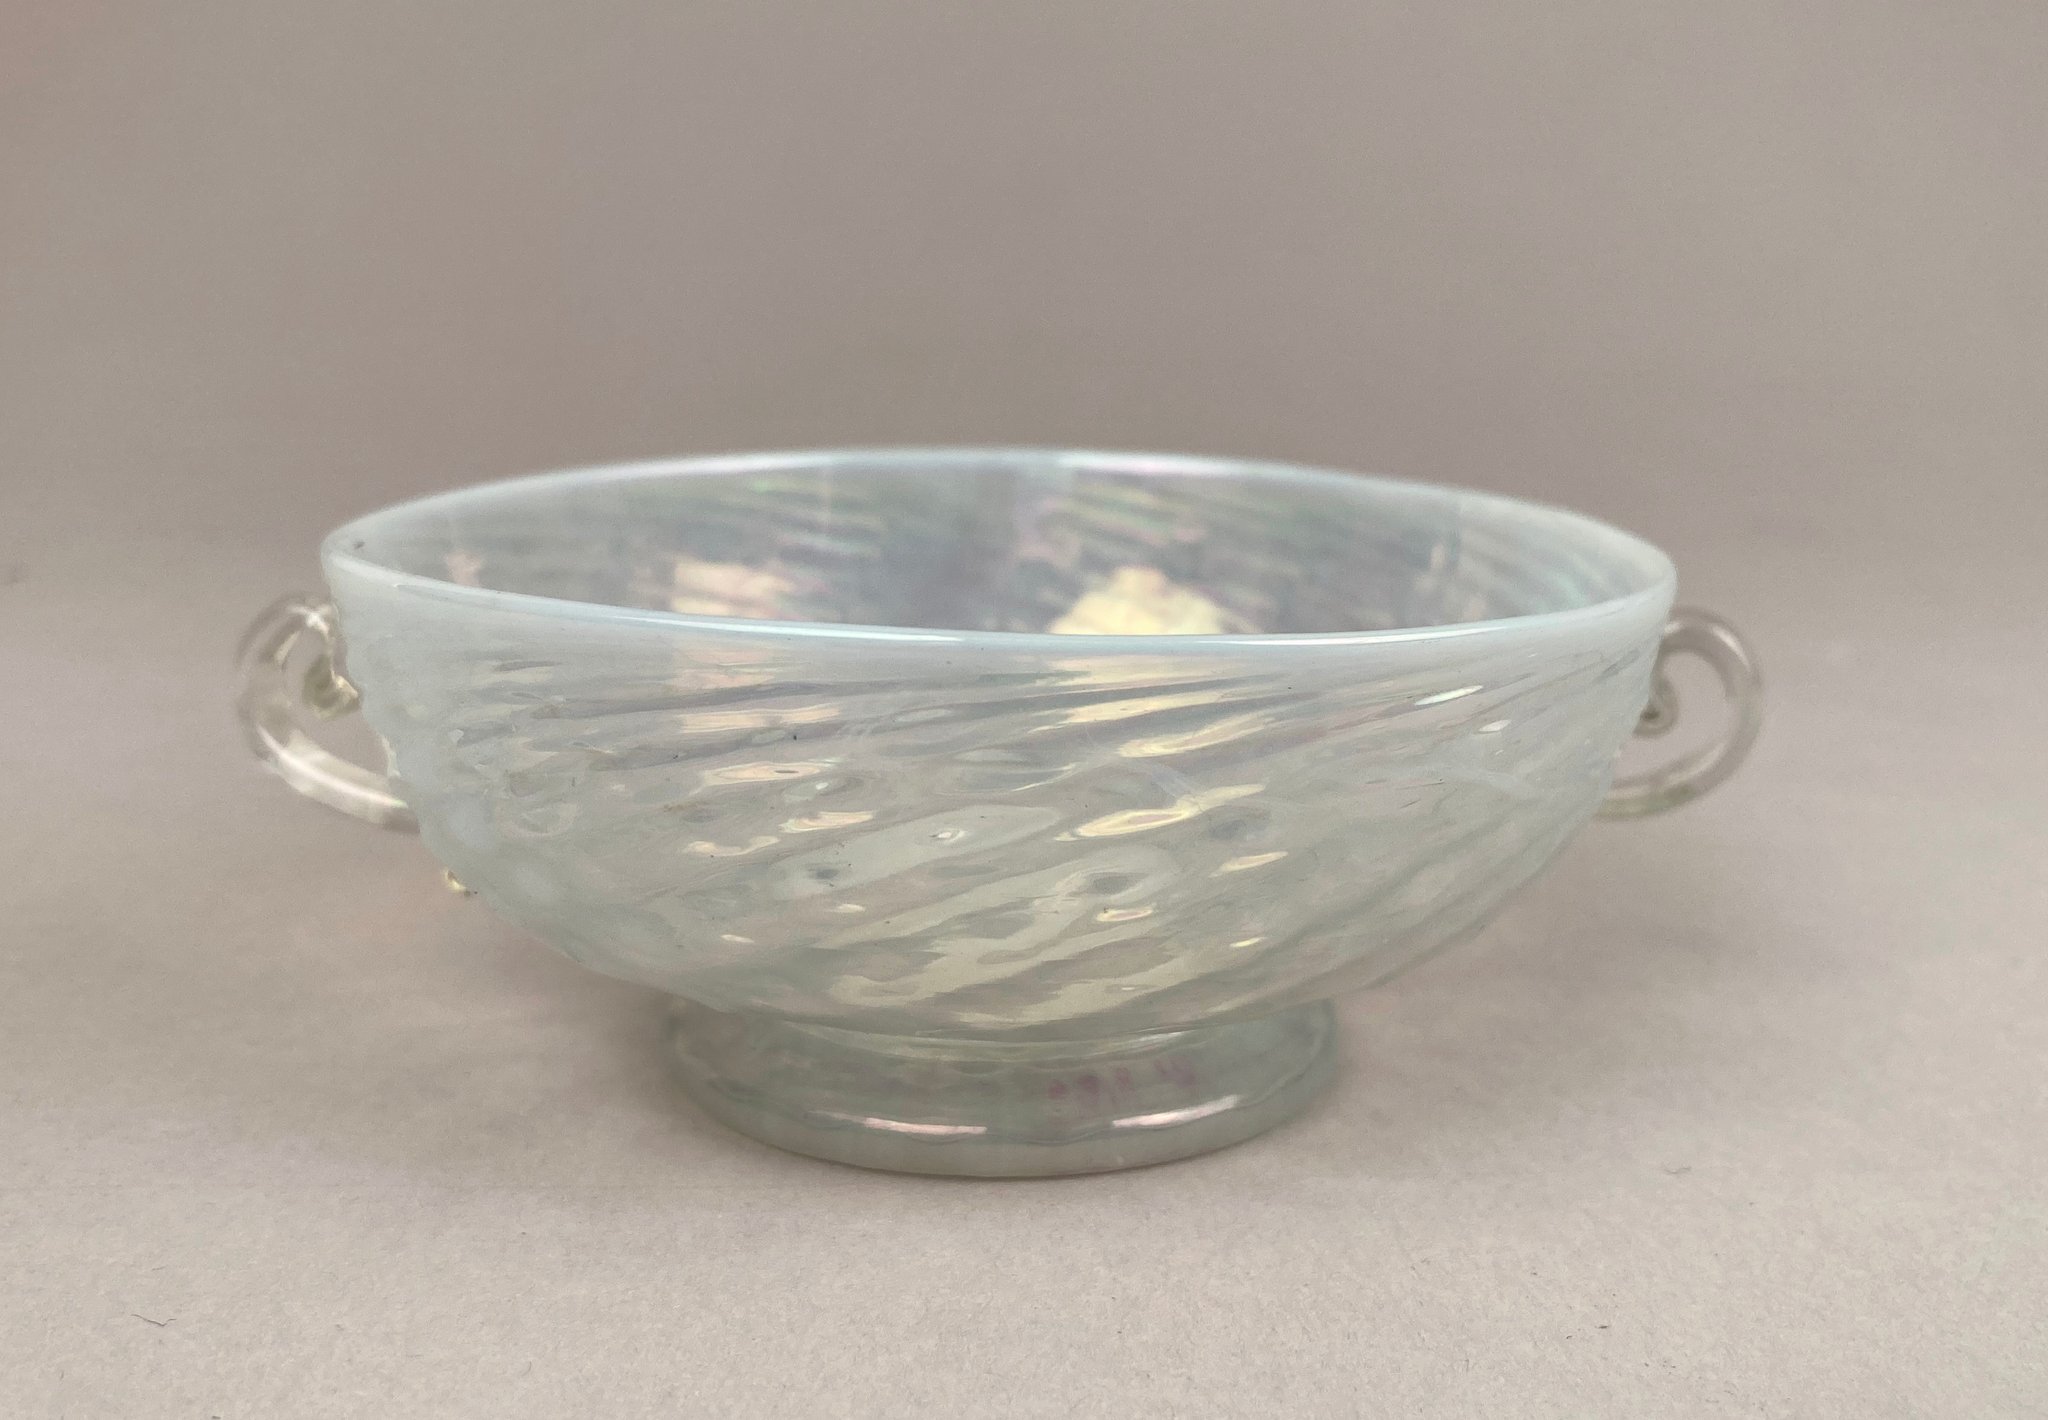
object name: cup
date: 1801-1900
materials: glass